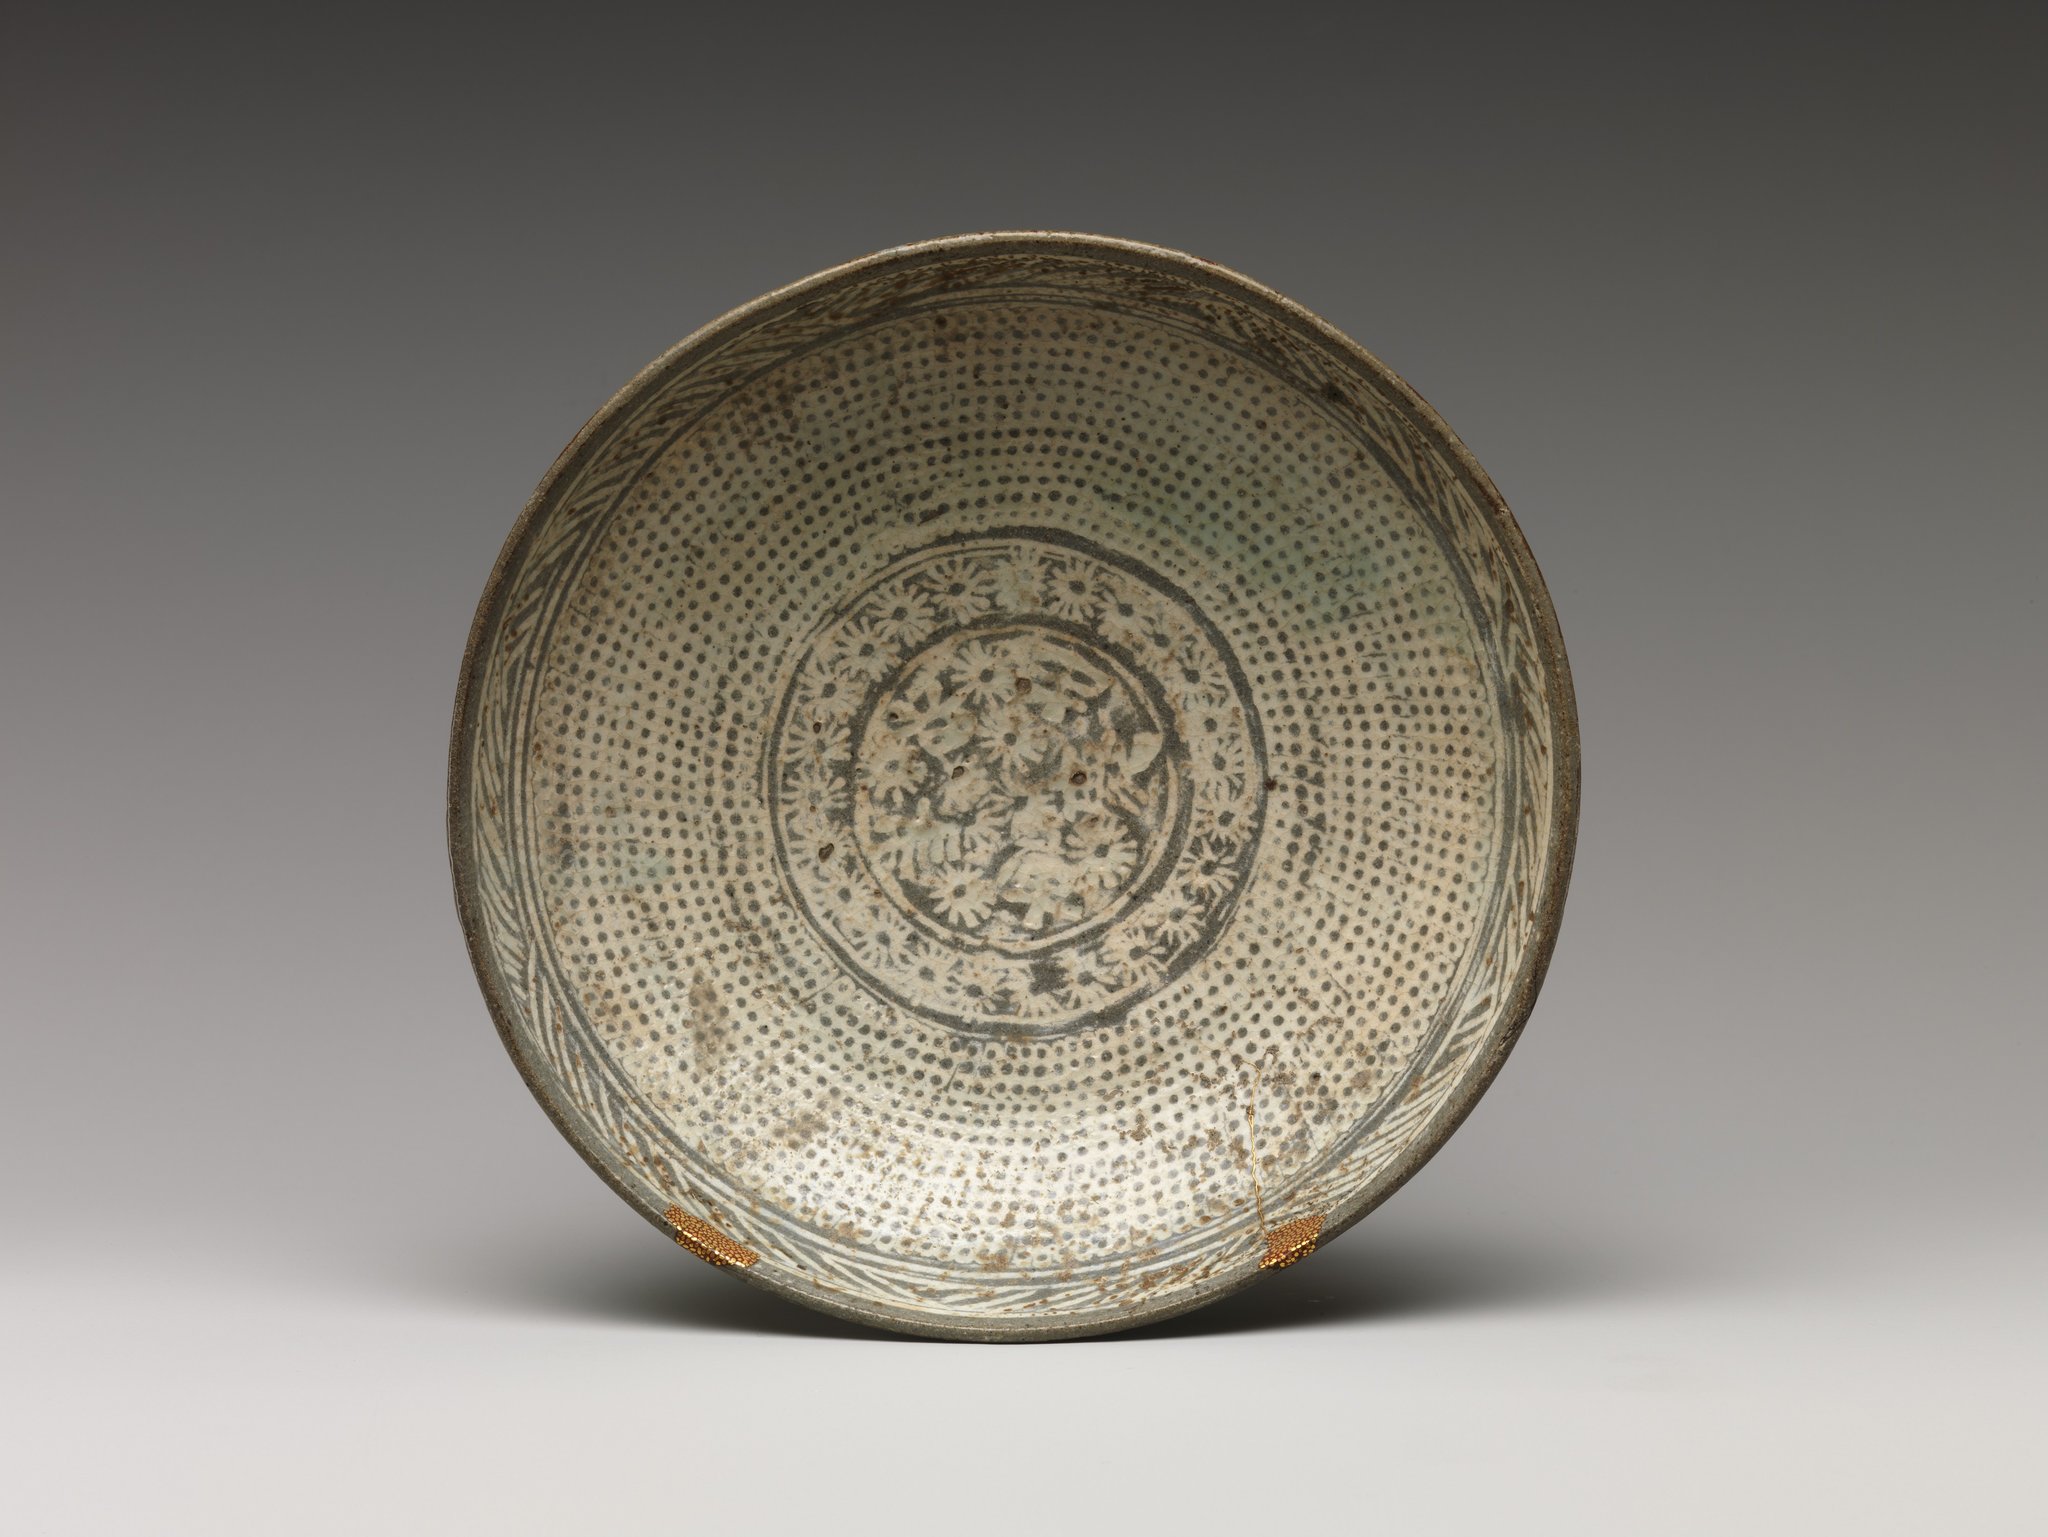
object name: dish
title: Dish with inscription and decorated with chrysanthemums and rows of dots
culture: korean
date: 1434-1466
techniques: stamping